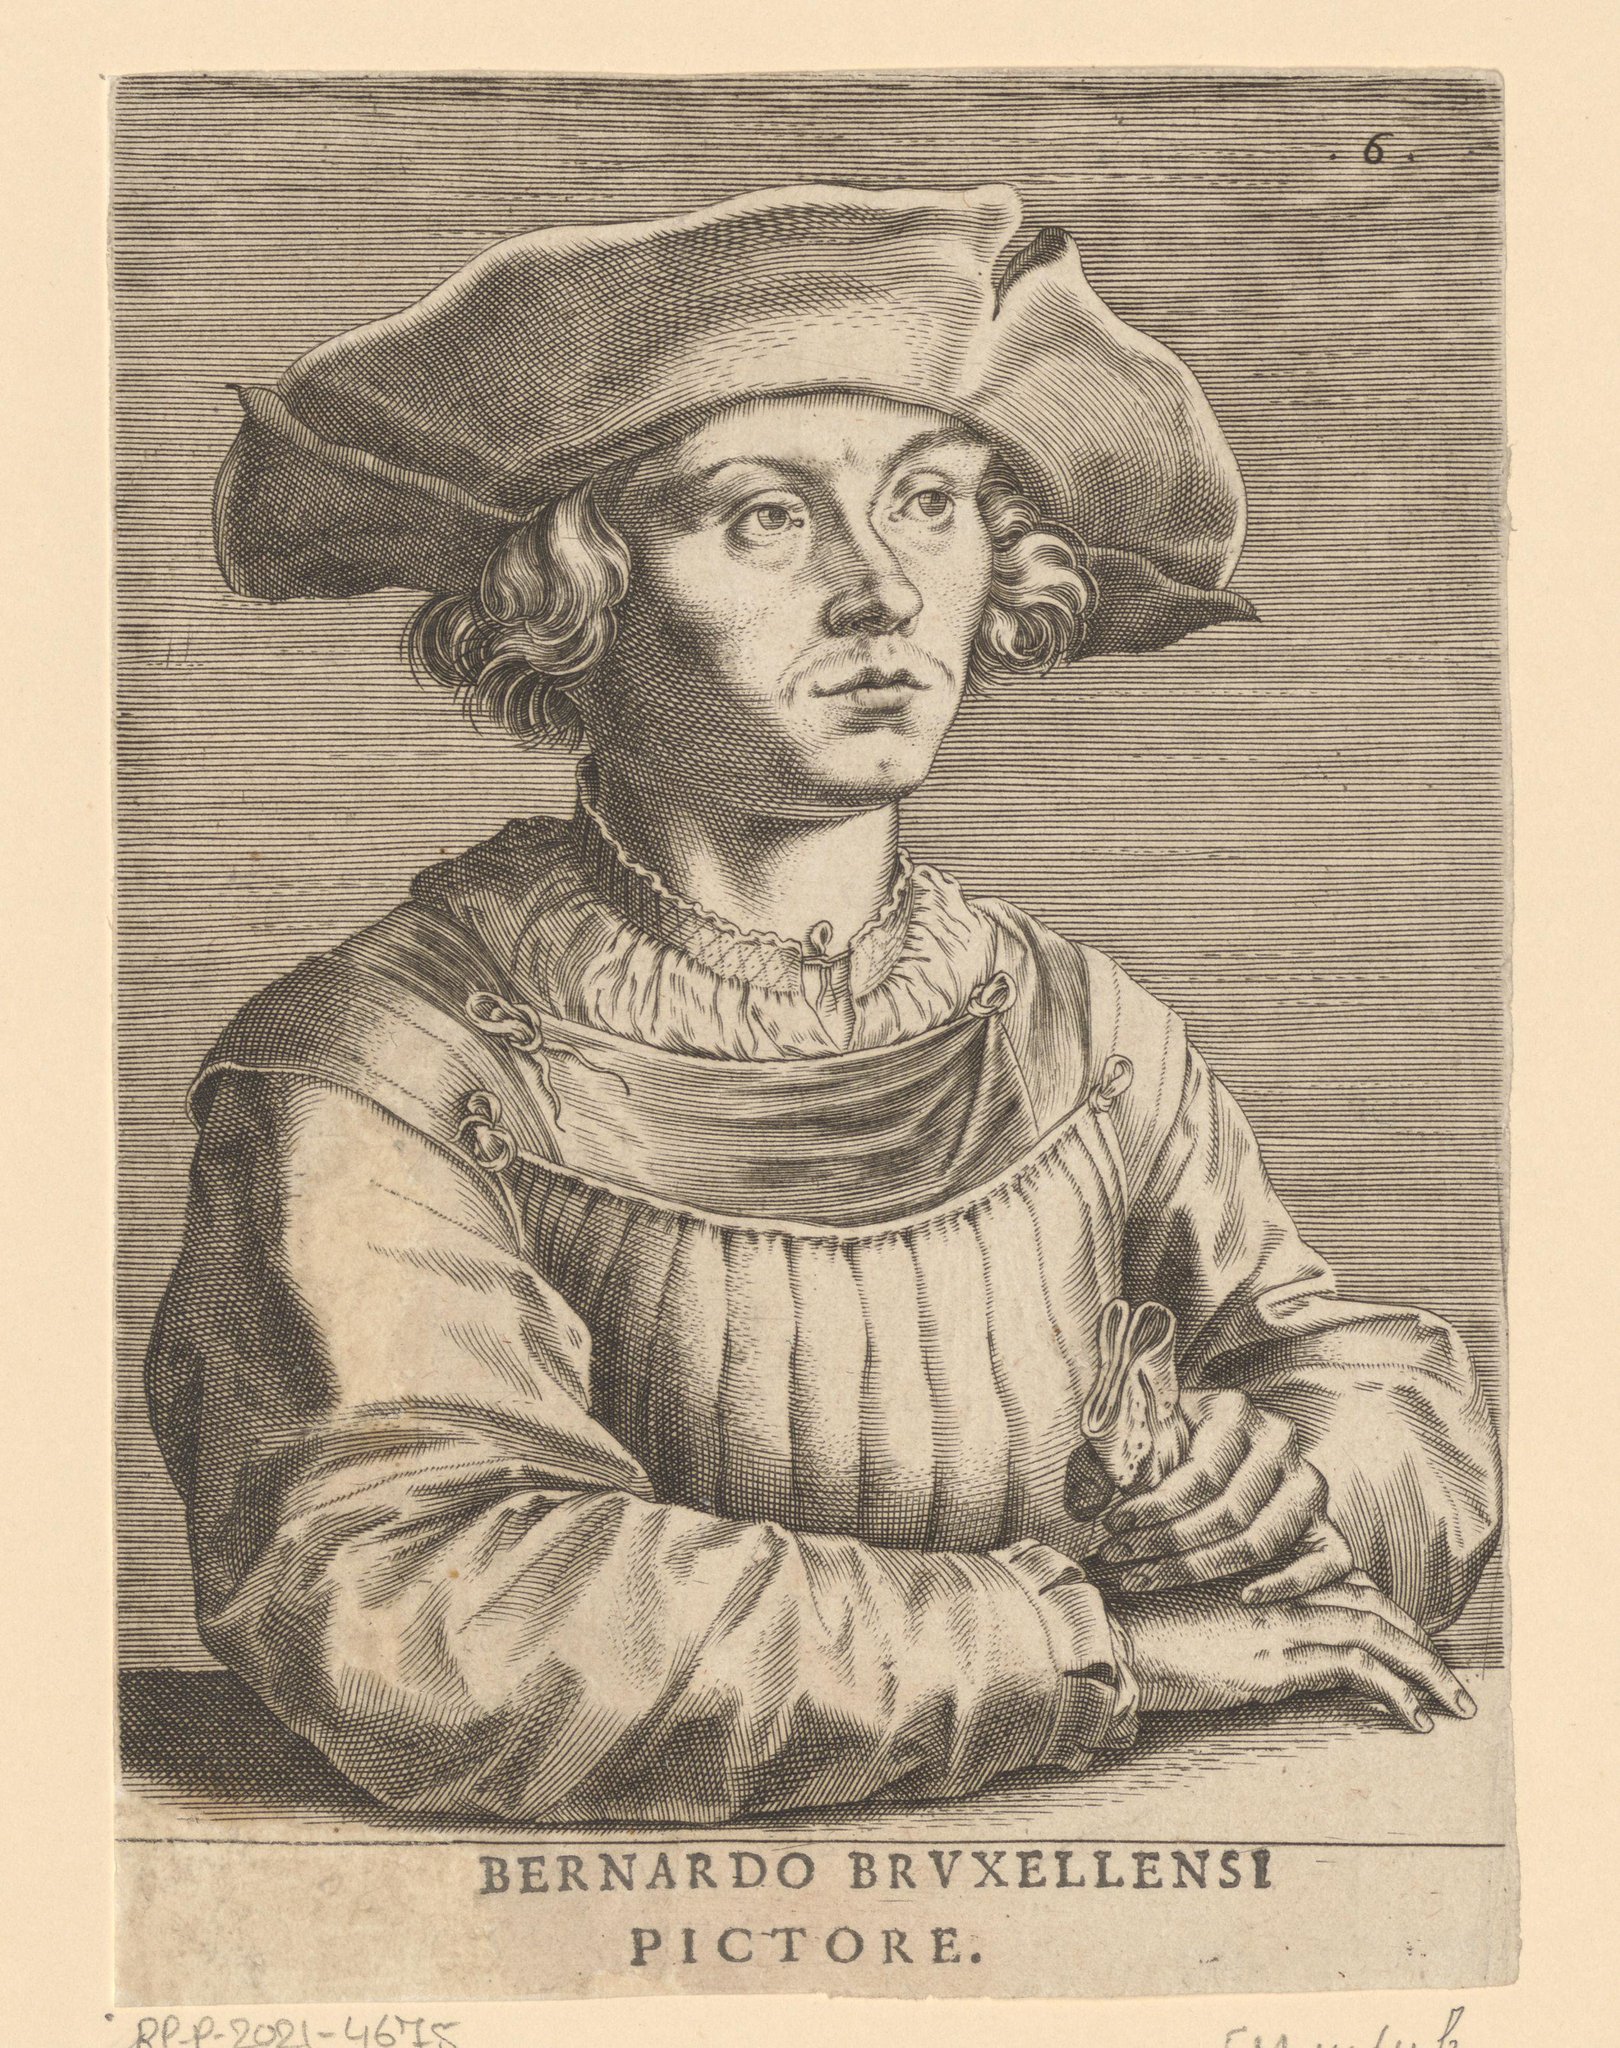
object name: print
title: Portret van Bernard van Orley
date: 1572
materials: paper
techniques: engraving, letterpress printing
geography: antwerp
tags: painter, draughtsman, bernard van orley, historical persons